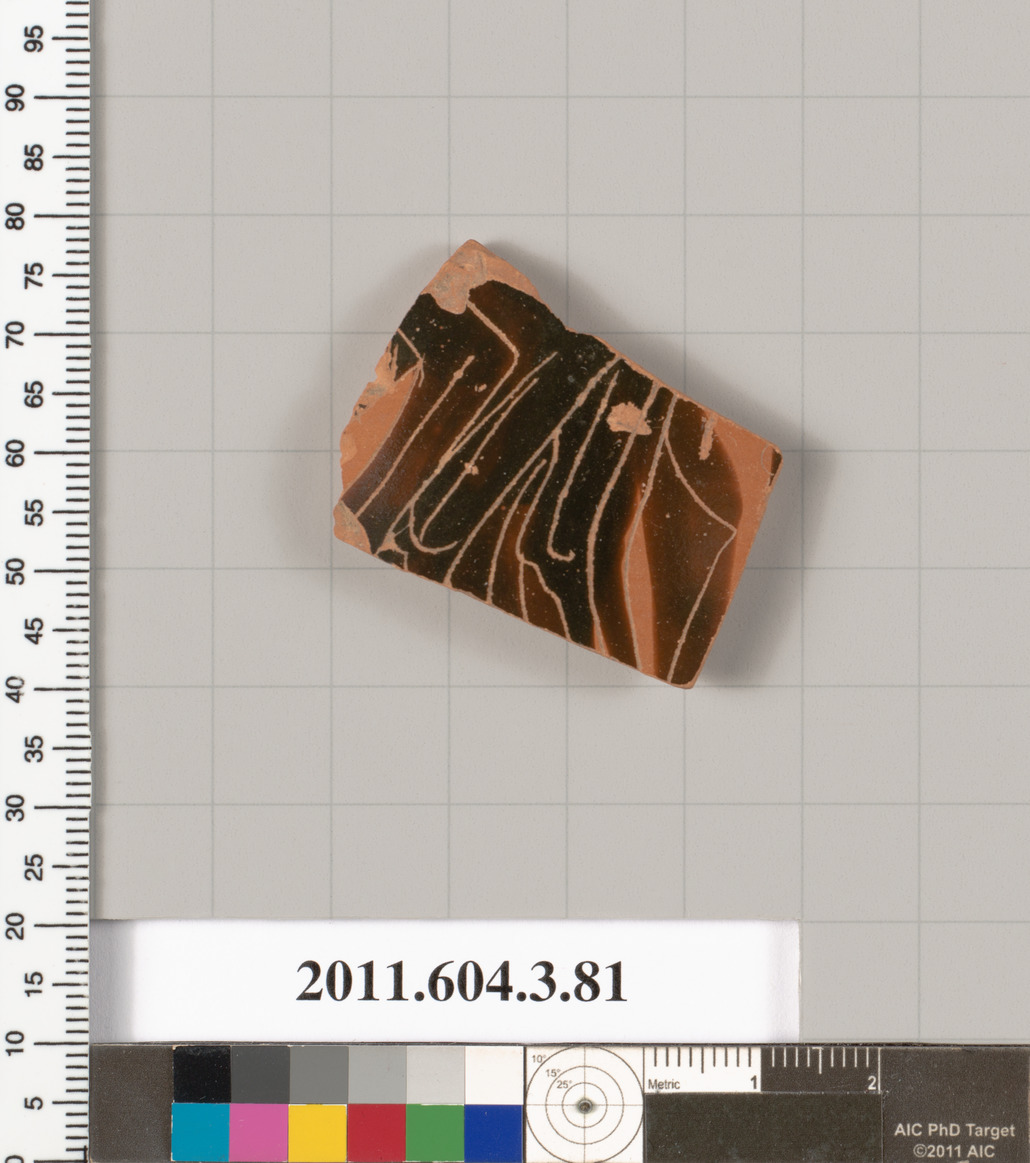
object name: amphora fragment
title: Terracotta fragment of an amphora (jar)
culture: greek, attic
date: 550-501 BCE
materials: terracotta